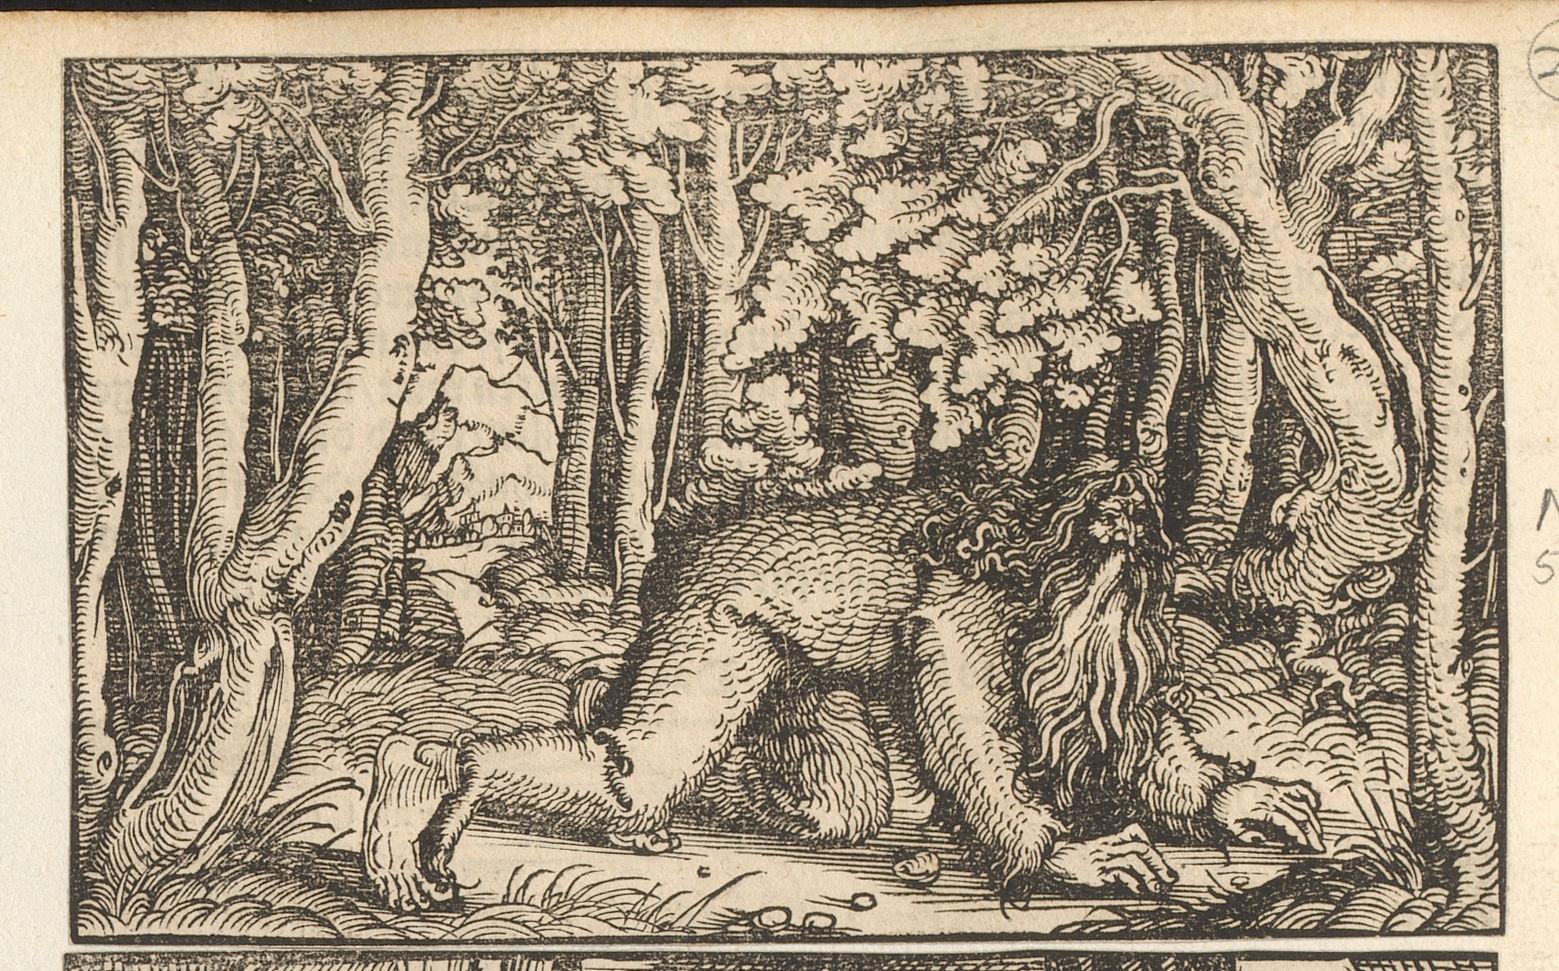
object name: print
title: Behaarde man kruipt door een bos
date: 1514-1531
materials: paper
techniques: letterpress printing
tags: bad, evil, wrong, wild man, wodewose, woodehouse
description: Deze prent is gebruikt in: Cicero, Marcus Tulius. Officia M.T.C. Ein Buch so Marcus Tullius Cicero der Römer zu seynem (...). [Vertaald uit het Latijn door] Johann von Schwarzenberg. Augsburg: Heinrich Steiner, 1531.